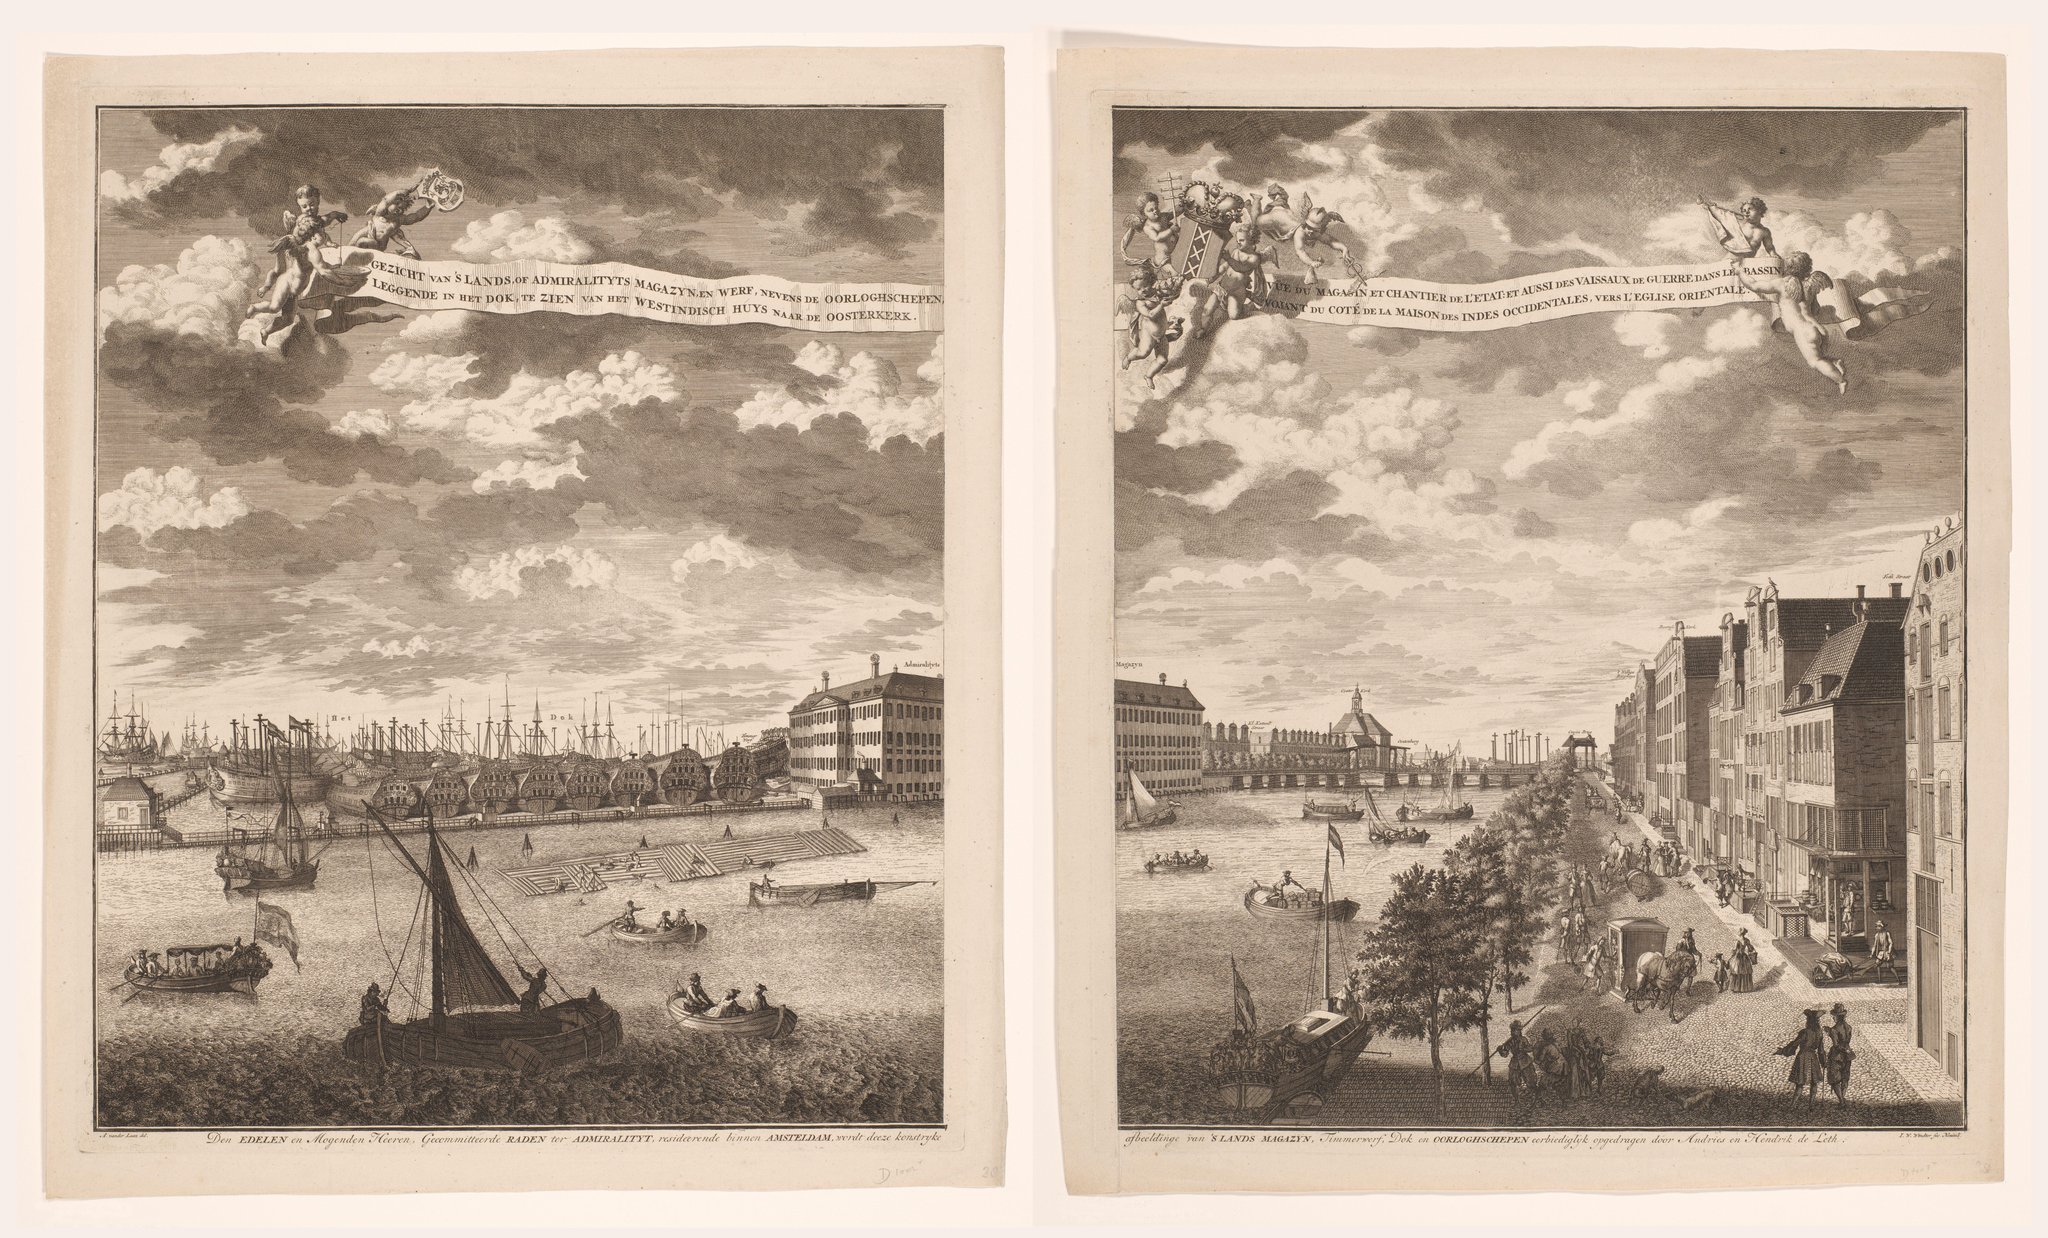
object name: print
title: Gezicht op 's Lands Zeemagazijn te Amsterdam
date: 1725-1731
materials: paper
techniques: etching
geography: nuremberg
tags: city-view, and landscape with man-made constructions, shipyard, shipdock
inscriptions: collector's mark: Lugt 2228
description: Dit object is omwille van een betere presentatie virtueel samengevoegd, maar bestaat fysiek uit losse onderdelen.